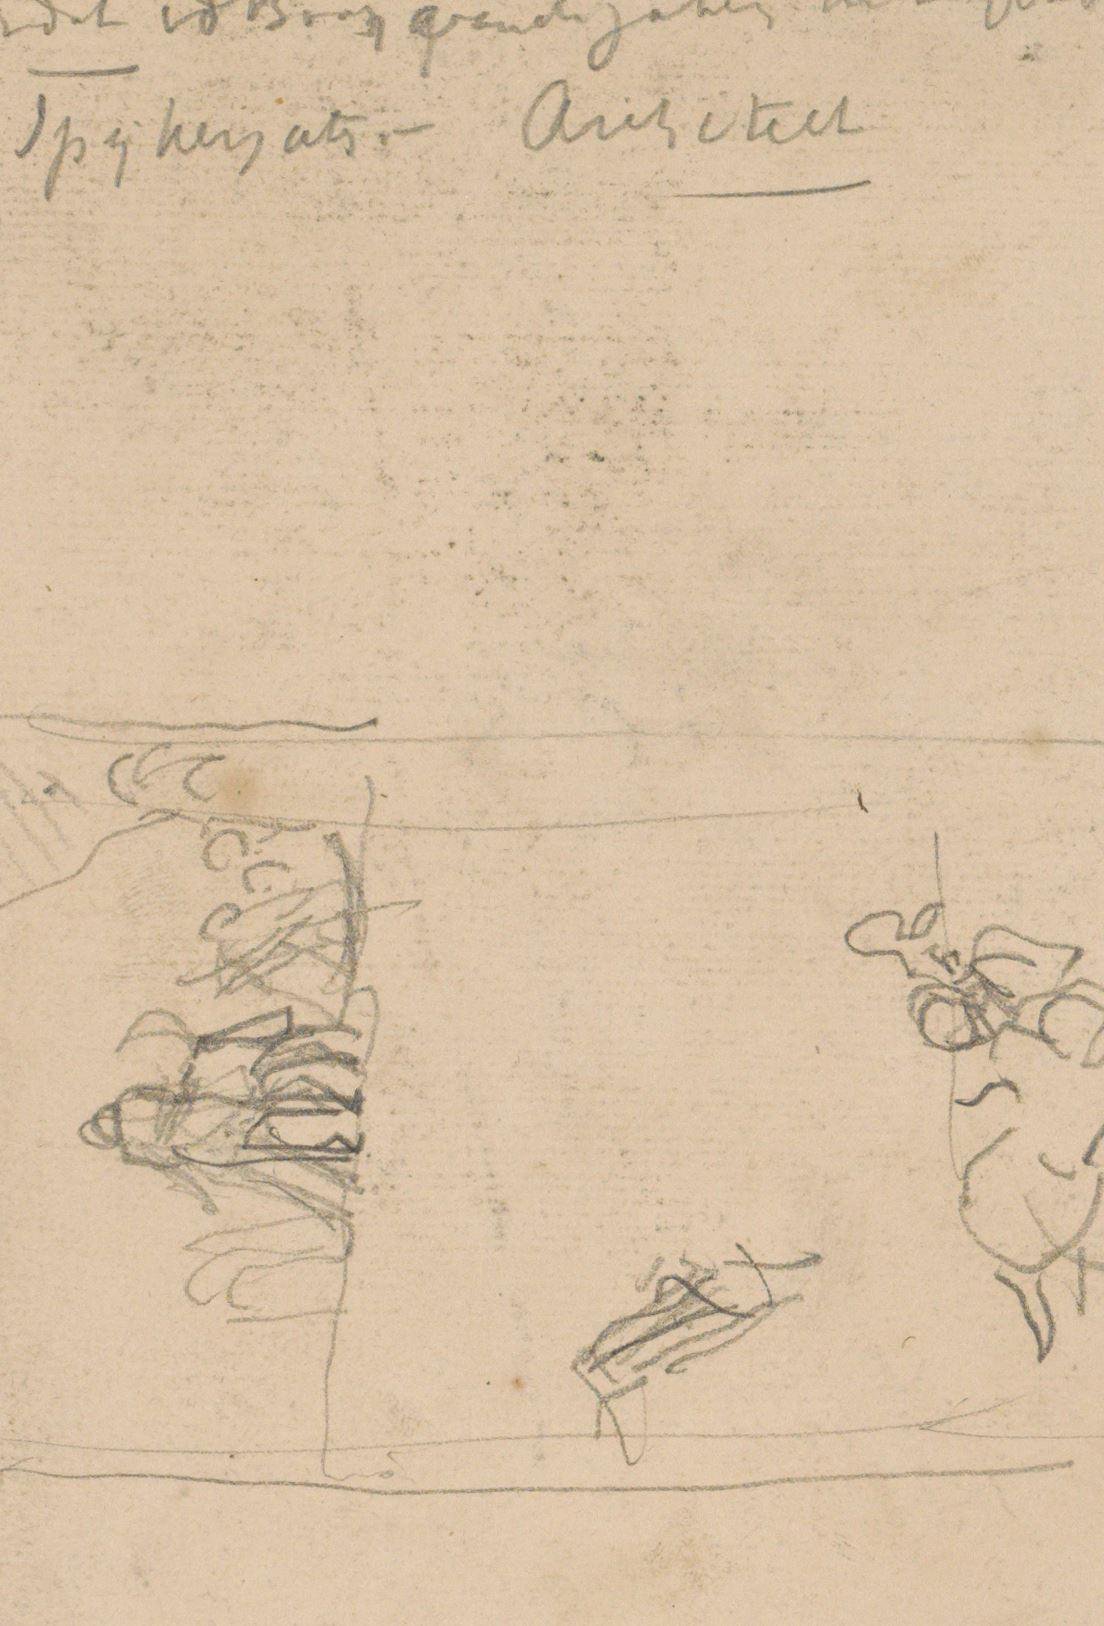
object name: sketchbook leaf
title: Figuurstudies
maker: george hendrik breitner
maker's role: draughtsman, painter, print maker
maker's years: 1857-1923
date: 1886-1923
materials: paper, pencil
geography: amsterdam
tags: adult woman, adult man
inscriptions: workshop stamp: Lugt 291d, annotation: ‘[...]’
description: Pagina 19 uit een schetsboek met 19 bladen en 9 losse tekeningen.